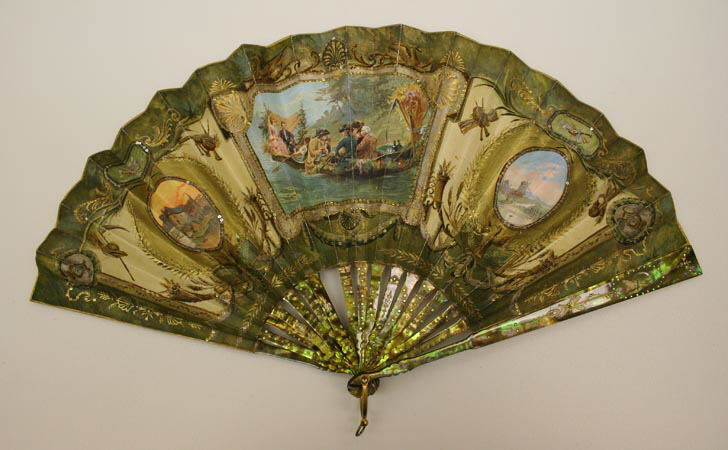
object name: fan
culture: french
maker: stern brothers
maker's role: designer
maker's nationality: american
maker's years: 1867-2001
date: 1867-1900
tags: men,women,boats